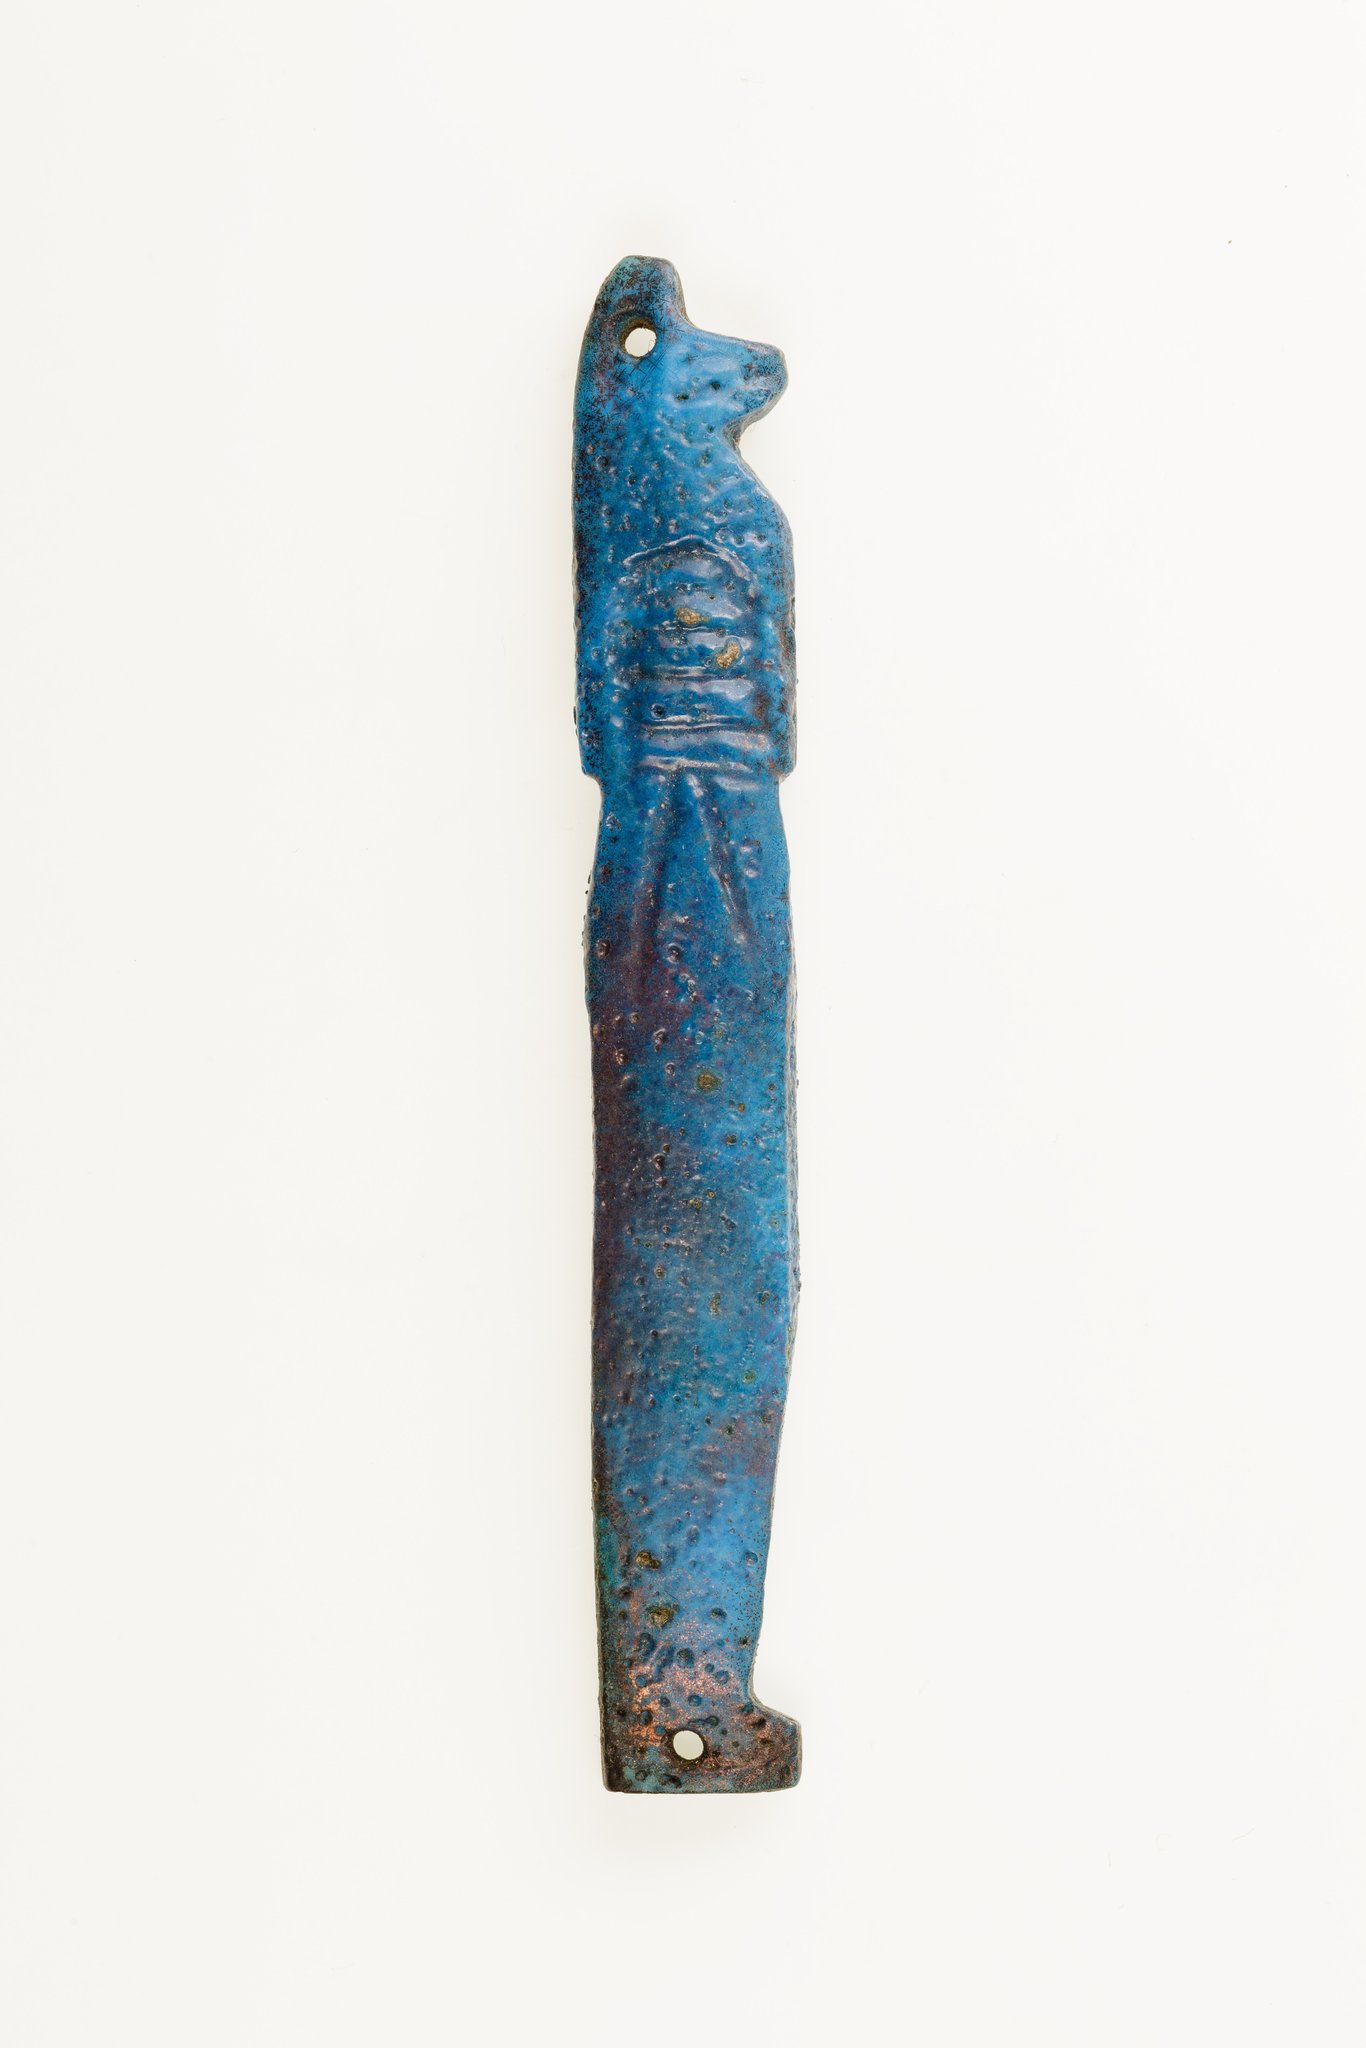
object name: amulet, son of horus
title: Son of Horus (Duamutef) from Bead Net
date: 1070-525 BCE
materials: faience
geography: egypt